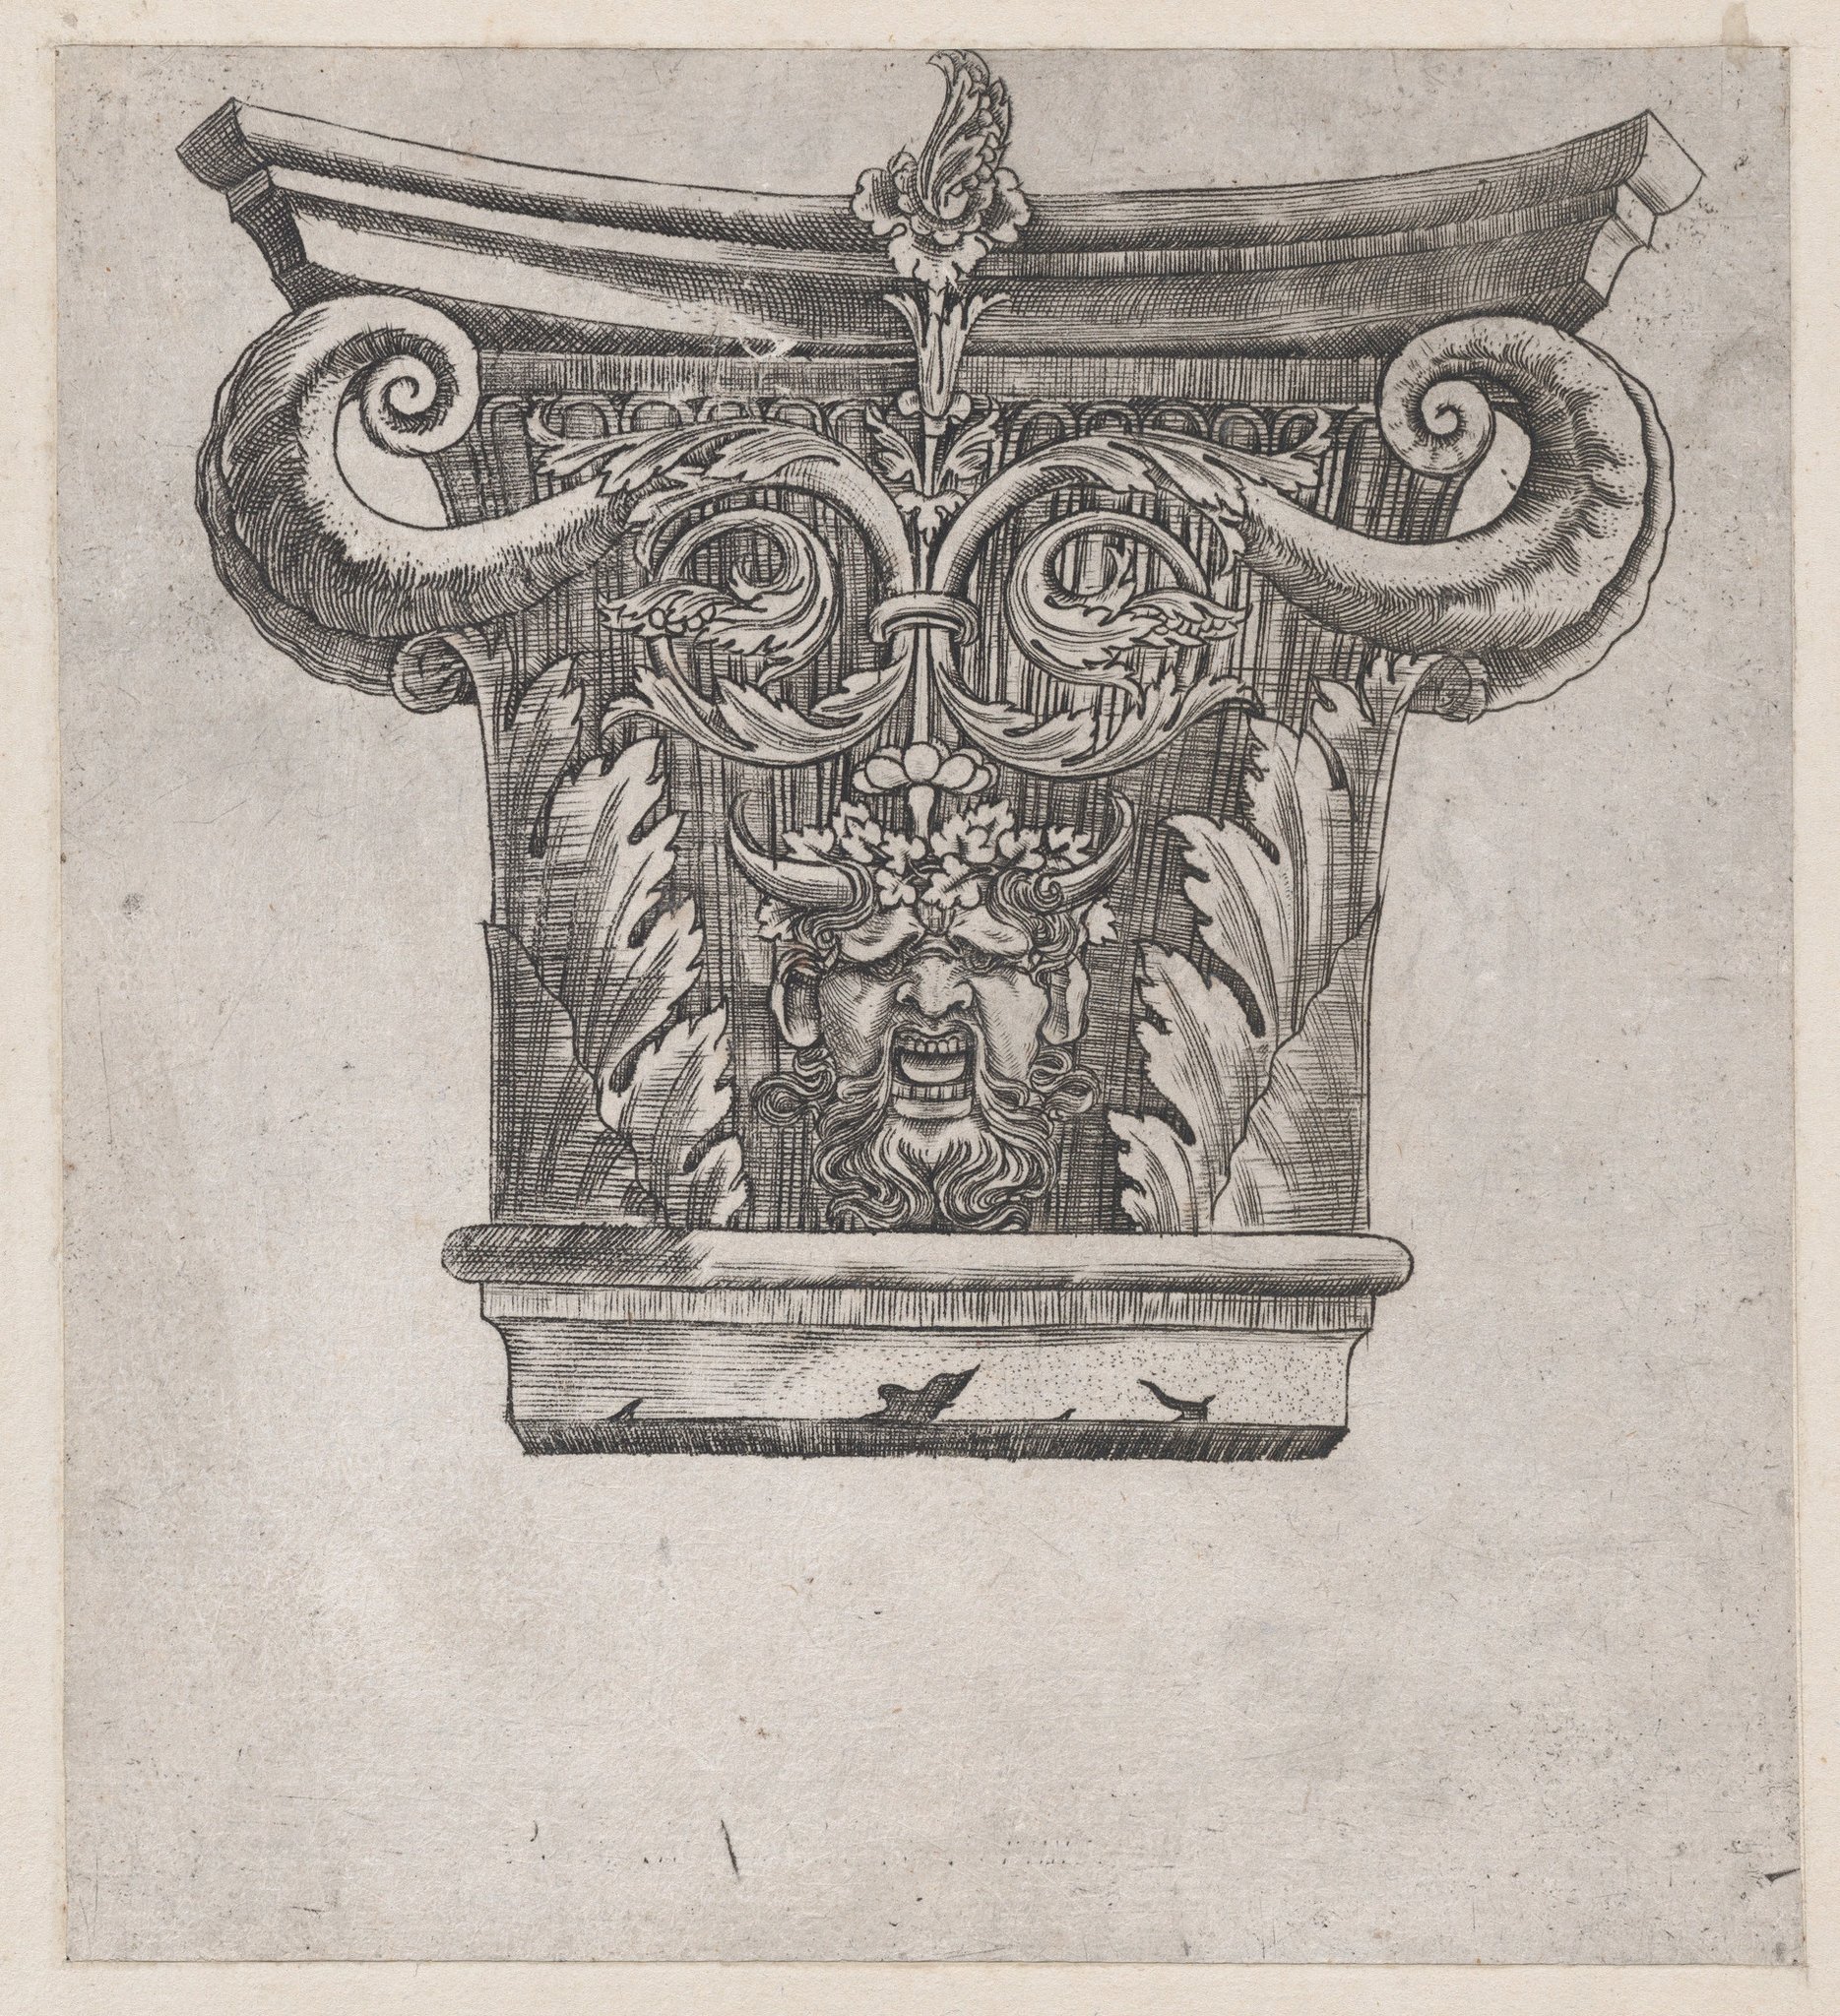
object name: print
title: Capital with peapod volutes and satyr head, from "Speculum Romanae Magnificentiae"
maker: monogrammist g.a. with the caltrop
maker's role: artist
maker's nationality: italian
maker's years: 1535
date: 1537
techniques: engraving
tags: capitals